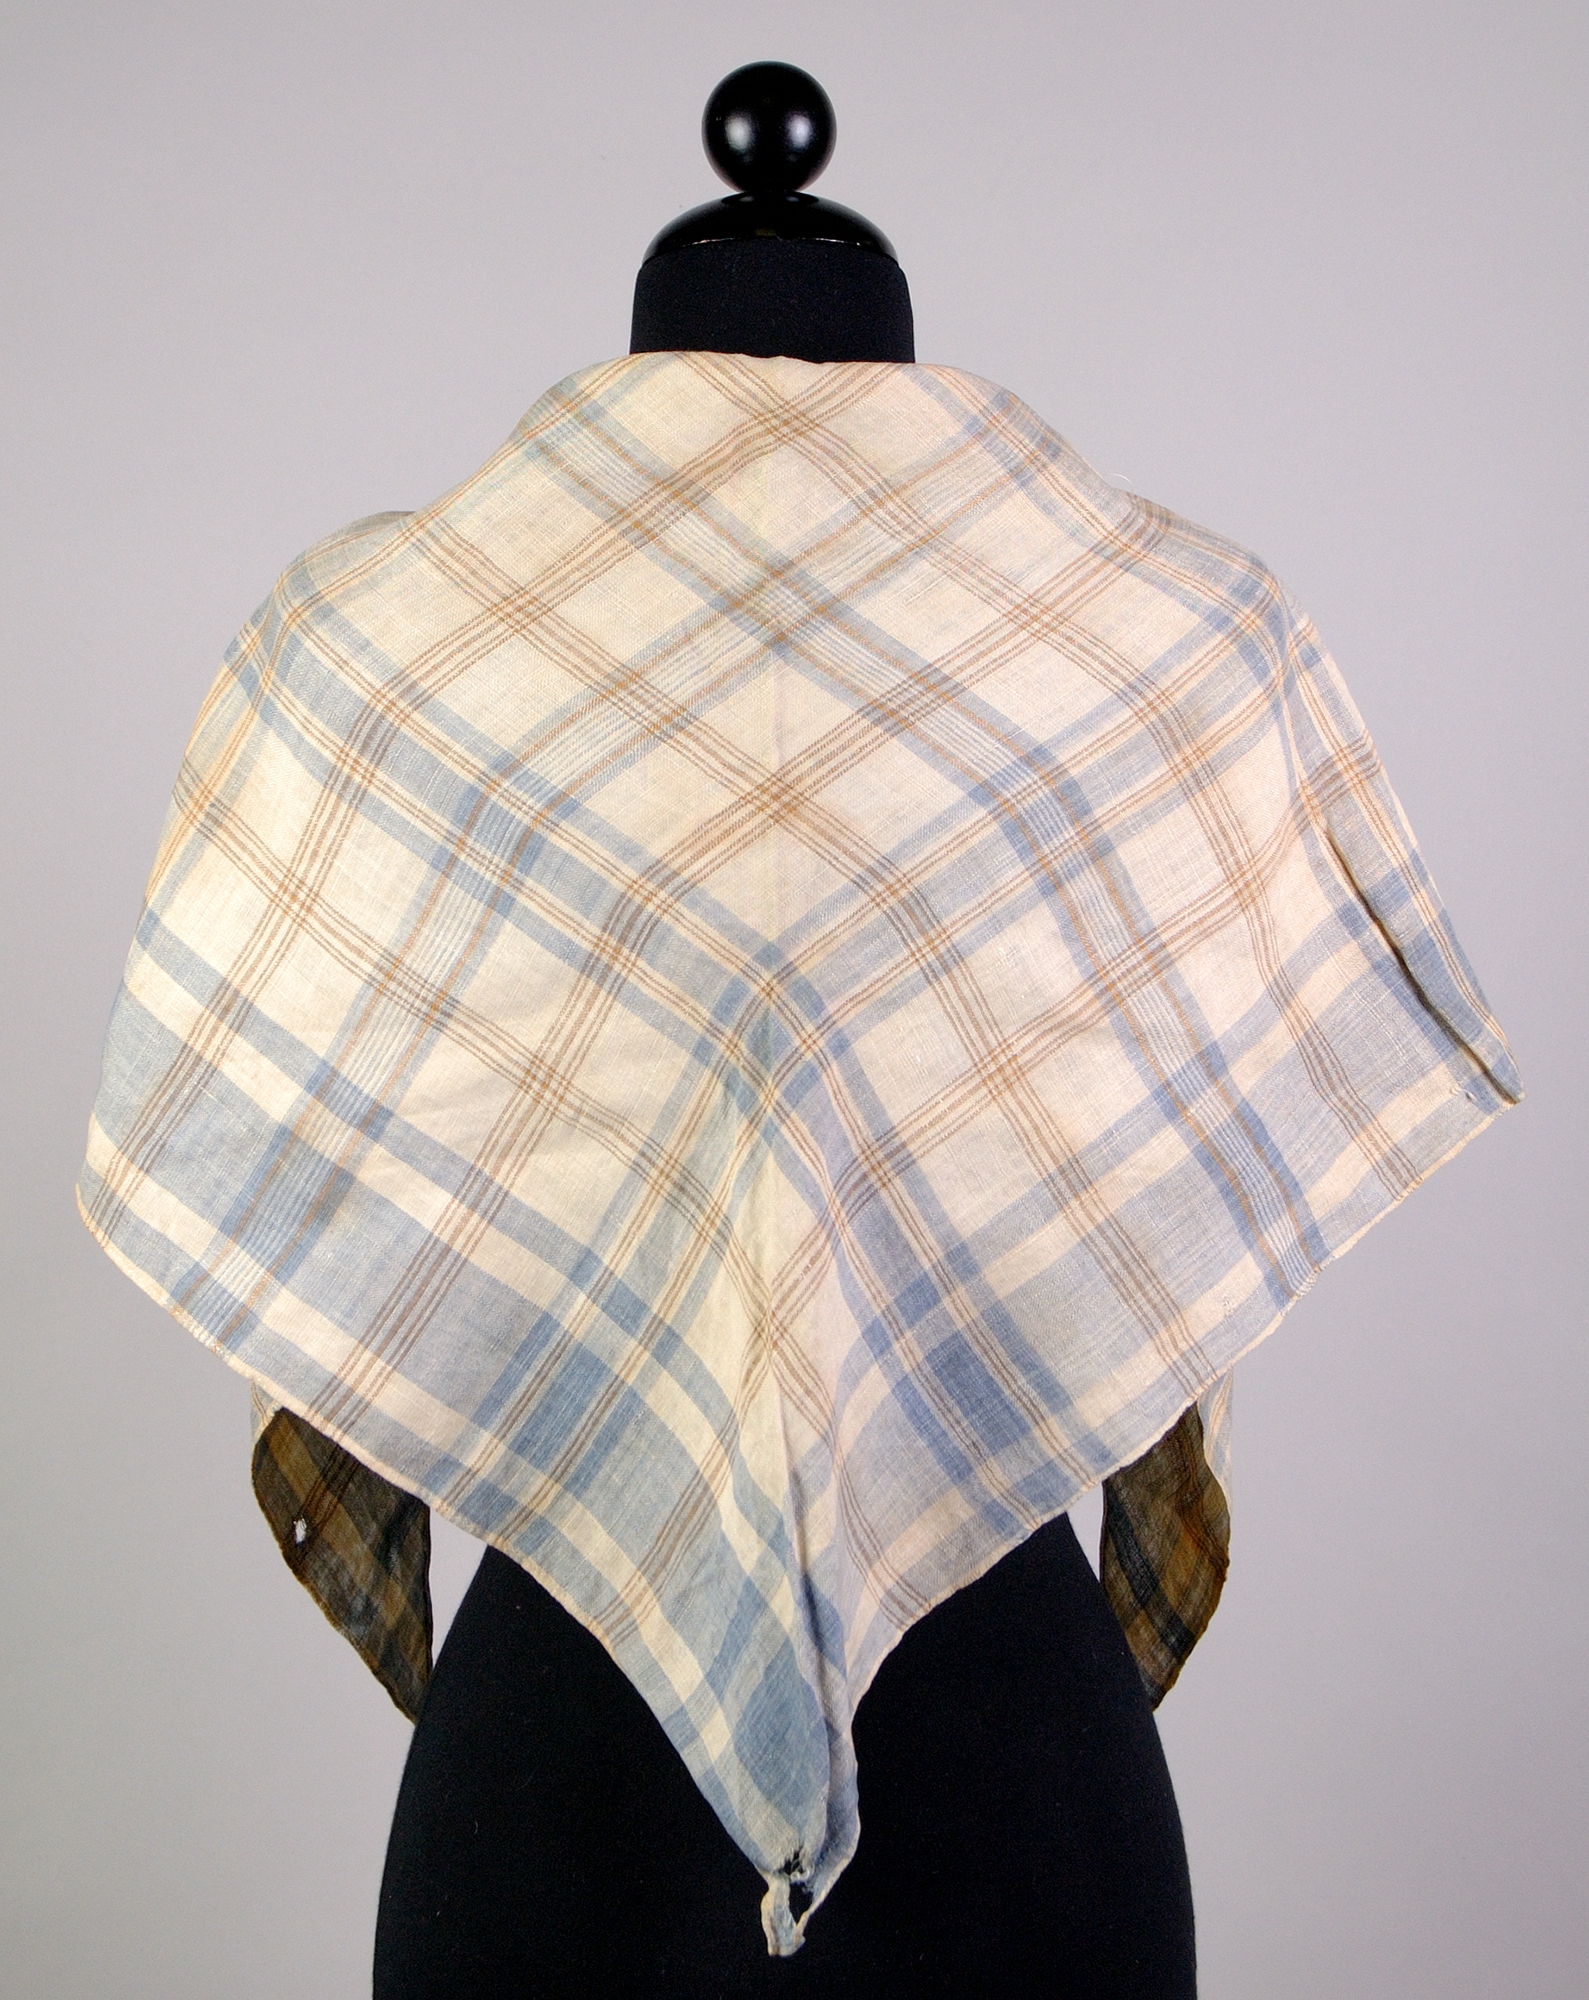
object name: kerchief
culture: american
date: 1750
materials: linen